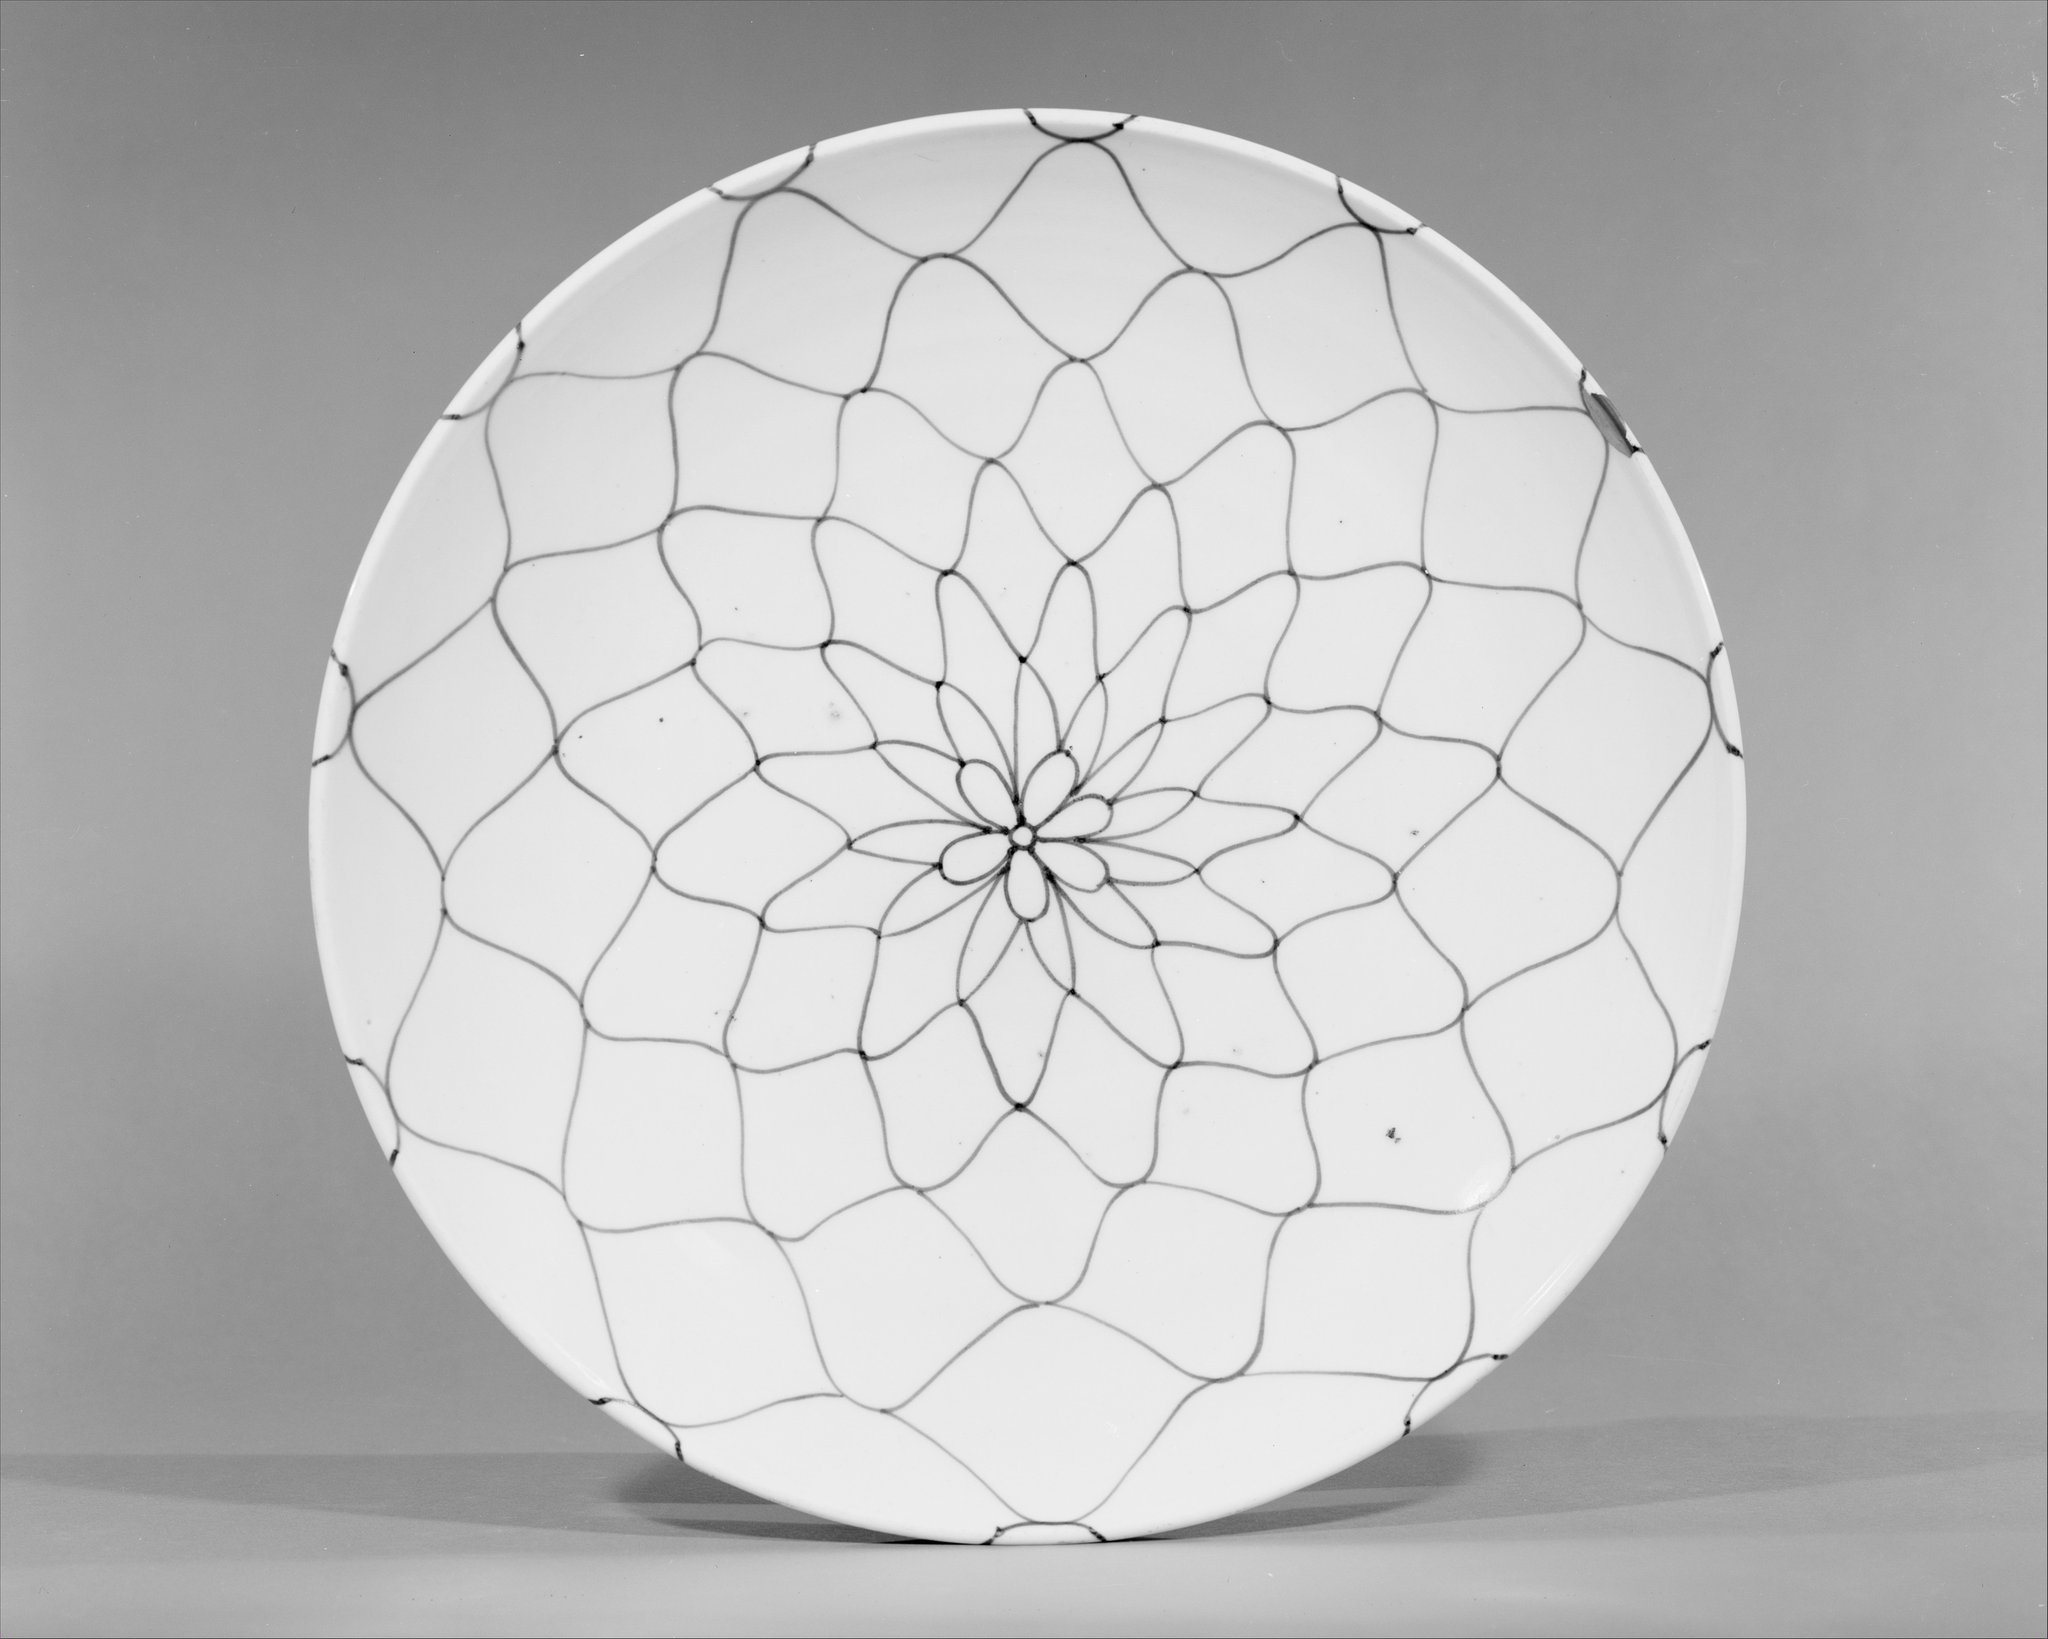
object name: dish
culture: japanese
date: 1615-1868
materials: porcelain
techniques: underglaze